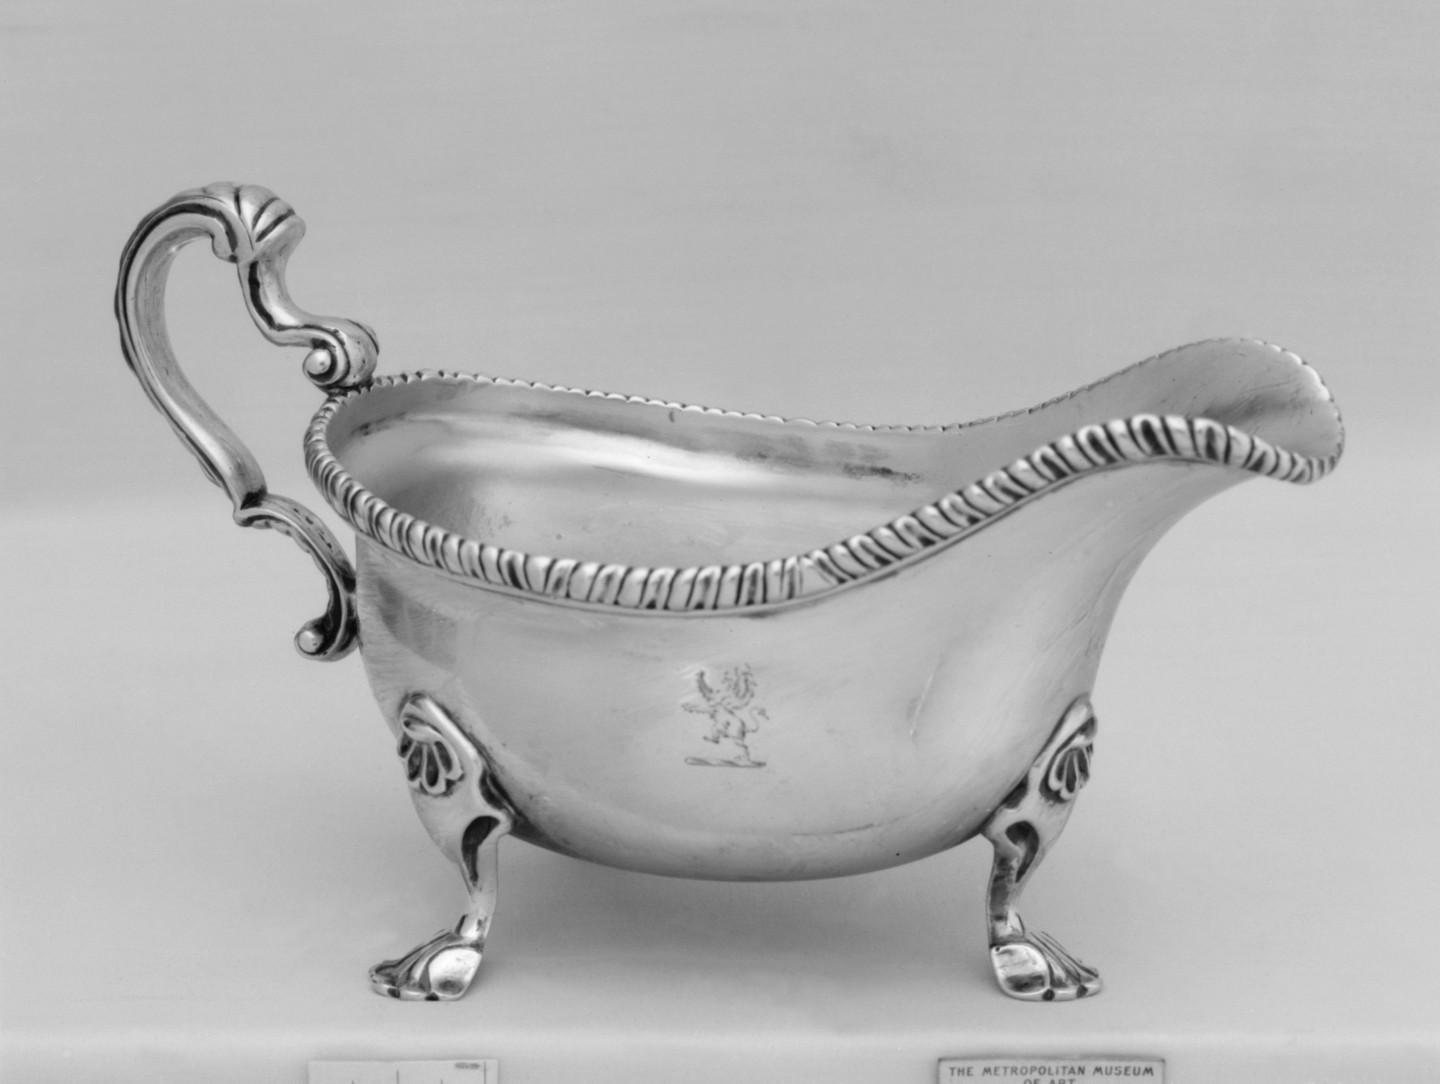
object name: sauceboat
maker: william sheen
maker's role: maker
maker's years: 1755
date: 1759-1760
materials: silver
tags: lions